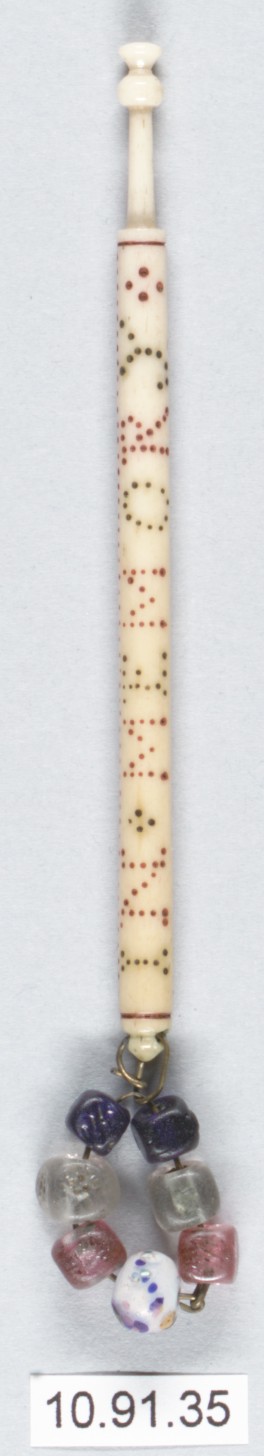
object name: bobbin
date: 1801-1900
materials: bone, metal